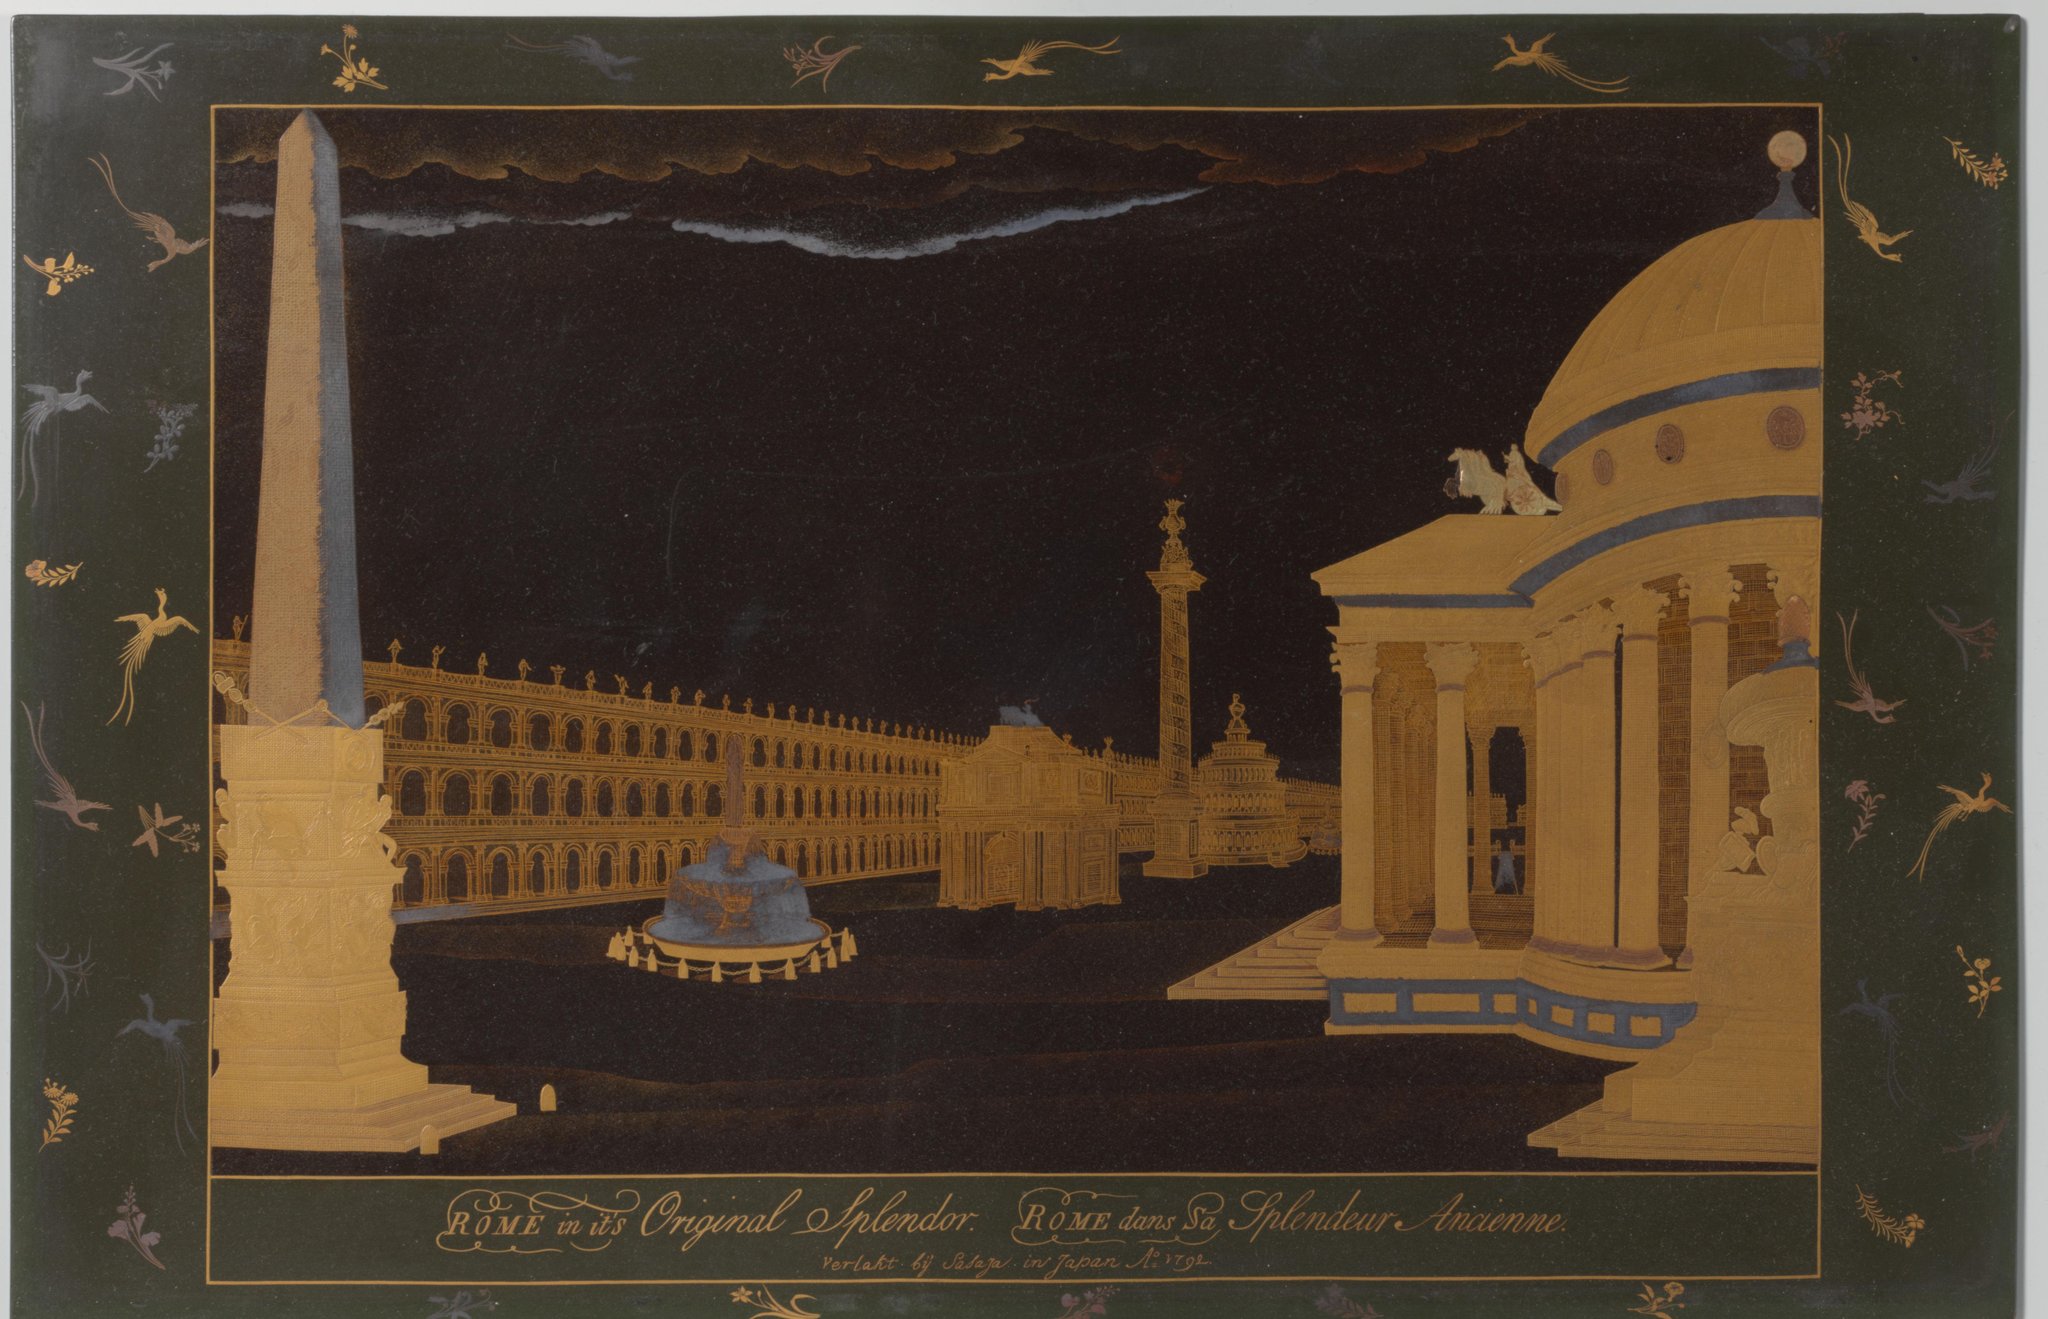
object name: panel ornament area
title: Paneel met lakwerkschildering op metalen ondergrond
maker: sasaya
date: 1792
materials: lacquer, metal, paint, wood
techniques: gilding, lacquer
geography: japan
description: Paneel met op metaal lakwerkschildering, uitgevoerd naar prenten. Voorstelling: Romeinse fantasiegebouwen met onderschrift: "ROME IN IT'S ORIGINAL SPLENDOR. ROME DANS SA SPLENDEUR ANCIENNE". Onder de titel gesigneerd: "VERLAKT BIJ SASAJA IN JAPAN Ao 1792". Het lakwerk is op een donkerbruine grond in goud- en zilverlak uitgevoerd. Het onderschrift evenals de omraming, waarin vogels en takken geschilderd zijn, op groene grond. De lijst is zwart geschilderd met vergulde binnenrand.